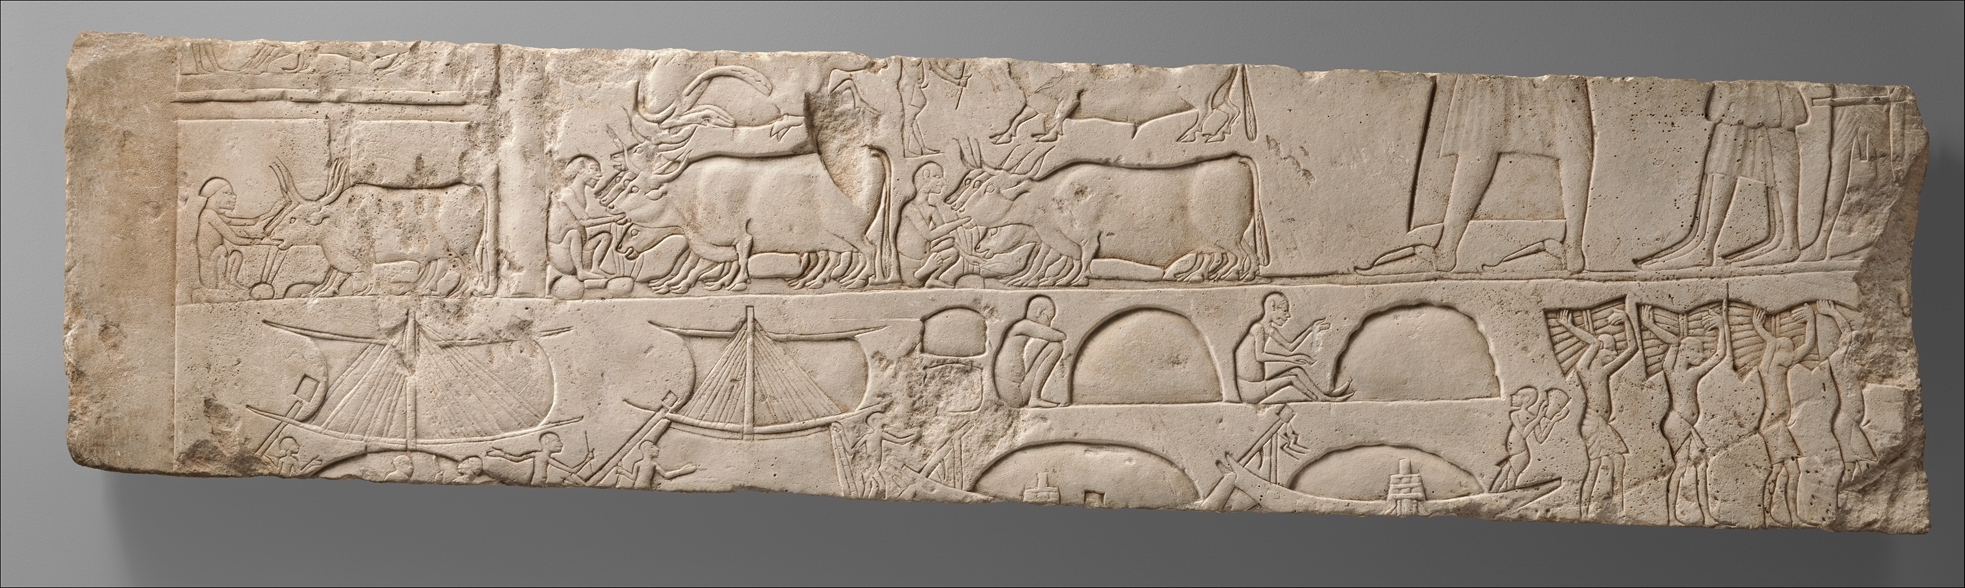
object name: relief, stable, ship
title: Relief Depicting Meryneith Inspecting His Stables and Ships Unloading Merchandise, from his tomb at Saqqara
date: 1349-1327 BCE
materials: limestone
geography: egypt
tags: animals,men,working,ships